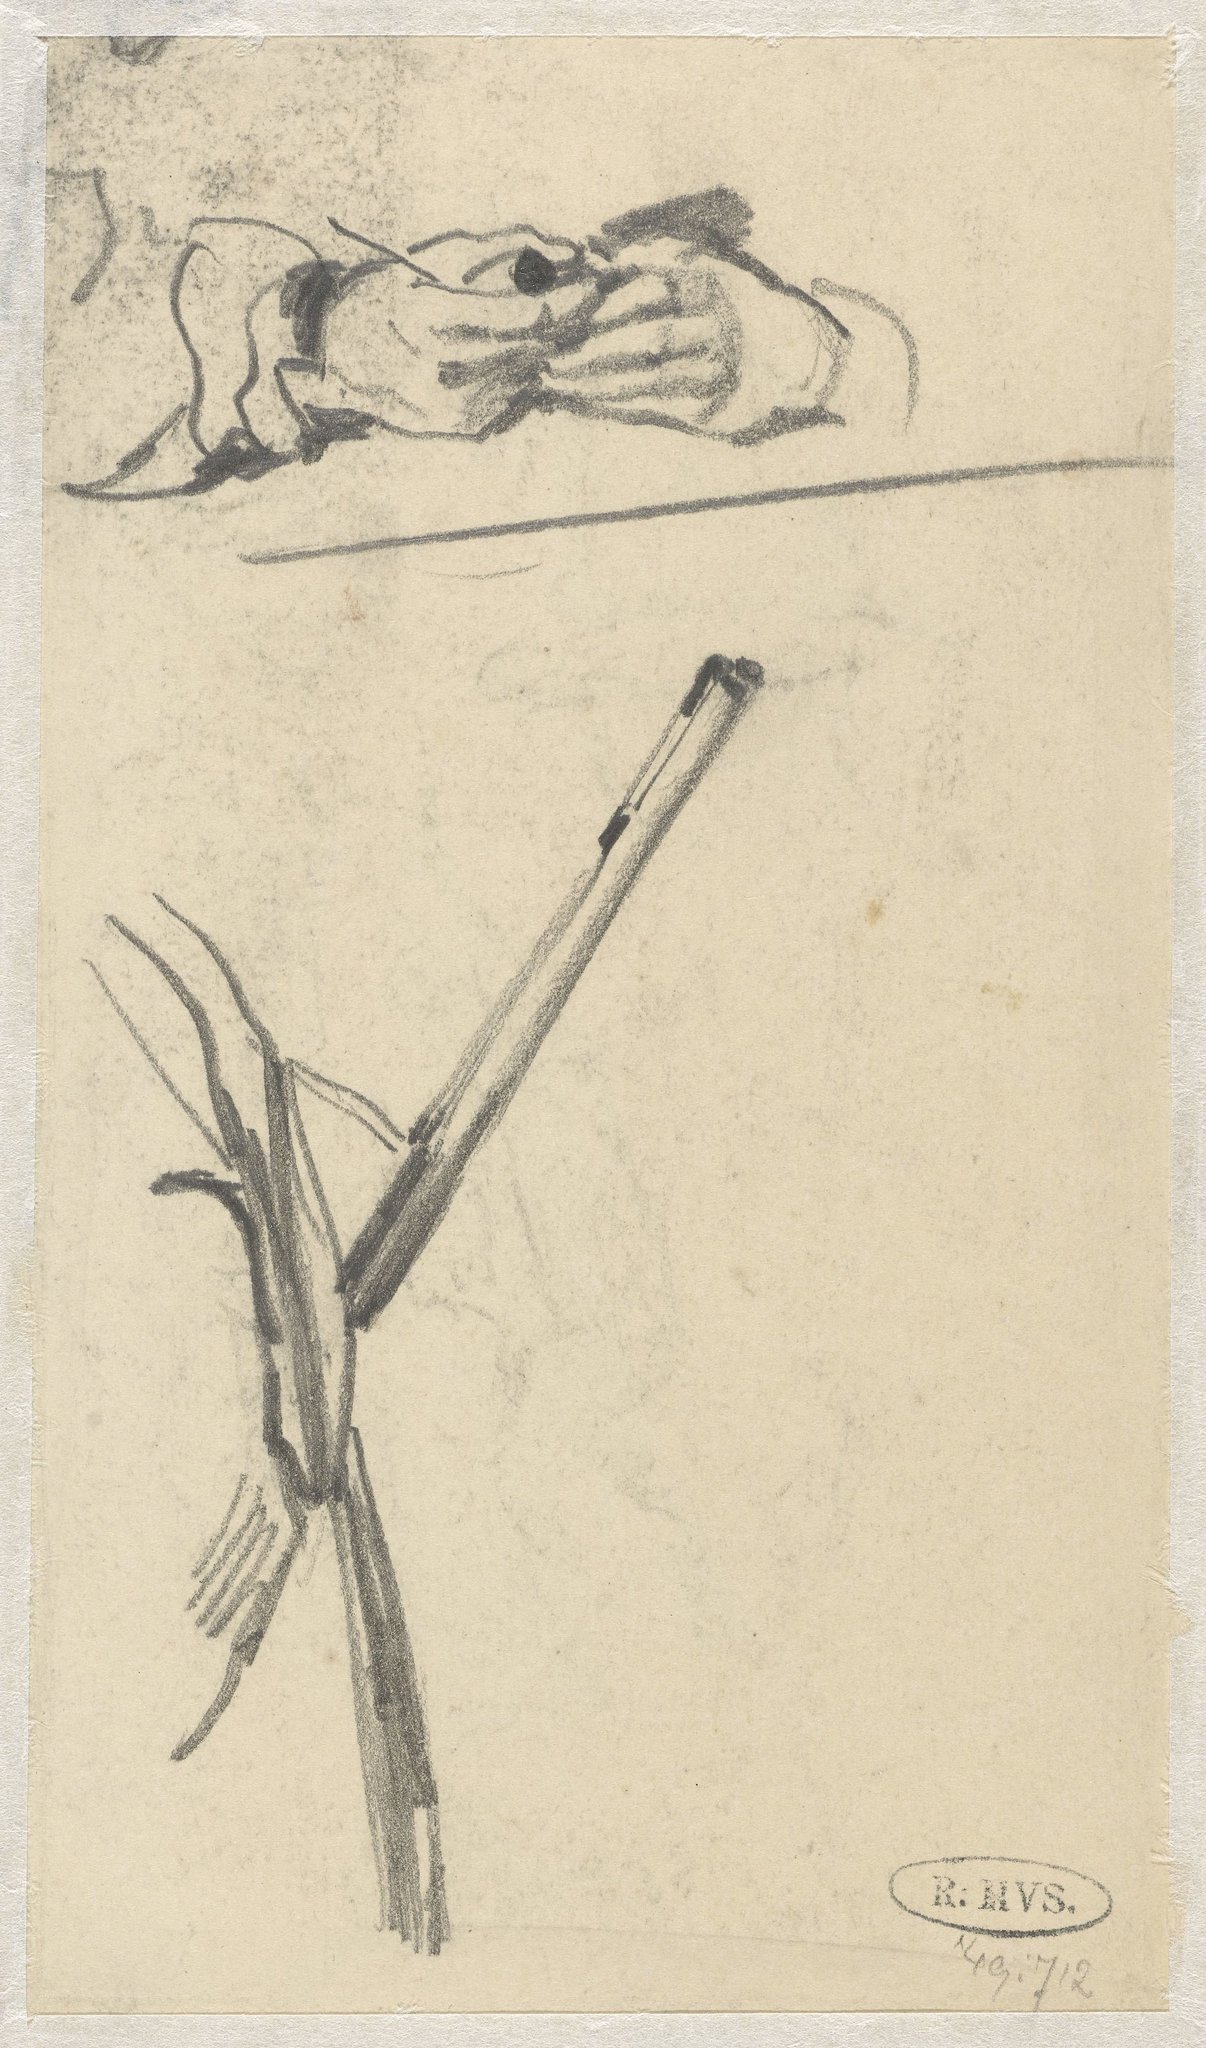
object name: drawing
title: Schets van een paar handen, ransel en geweer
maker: guillaume anne van der brugghen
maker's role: draughtsman, print maker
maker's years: 1812-1891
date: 1821-1891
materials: paper, pencil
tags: hunter